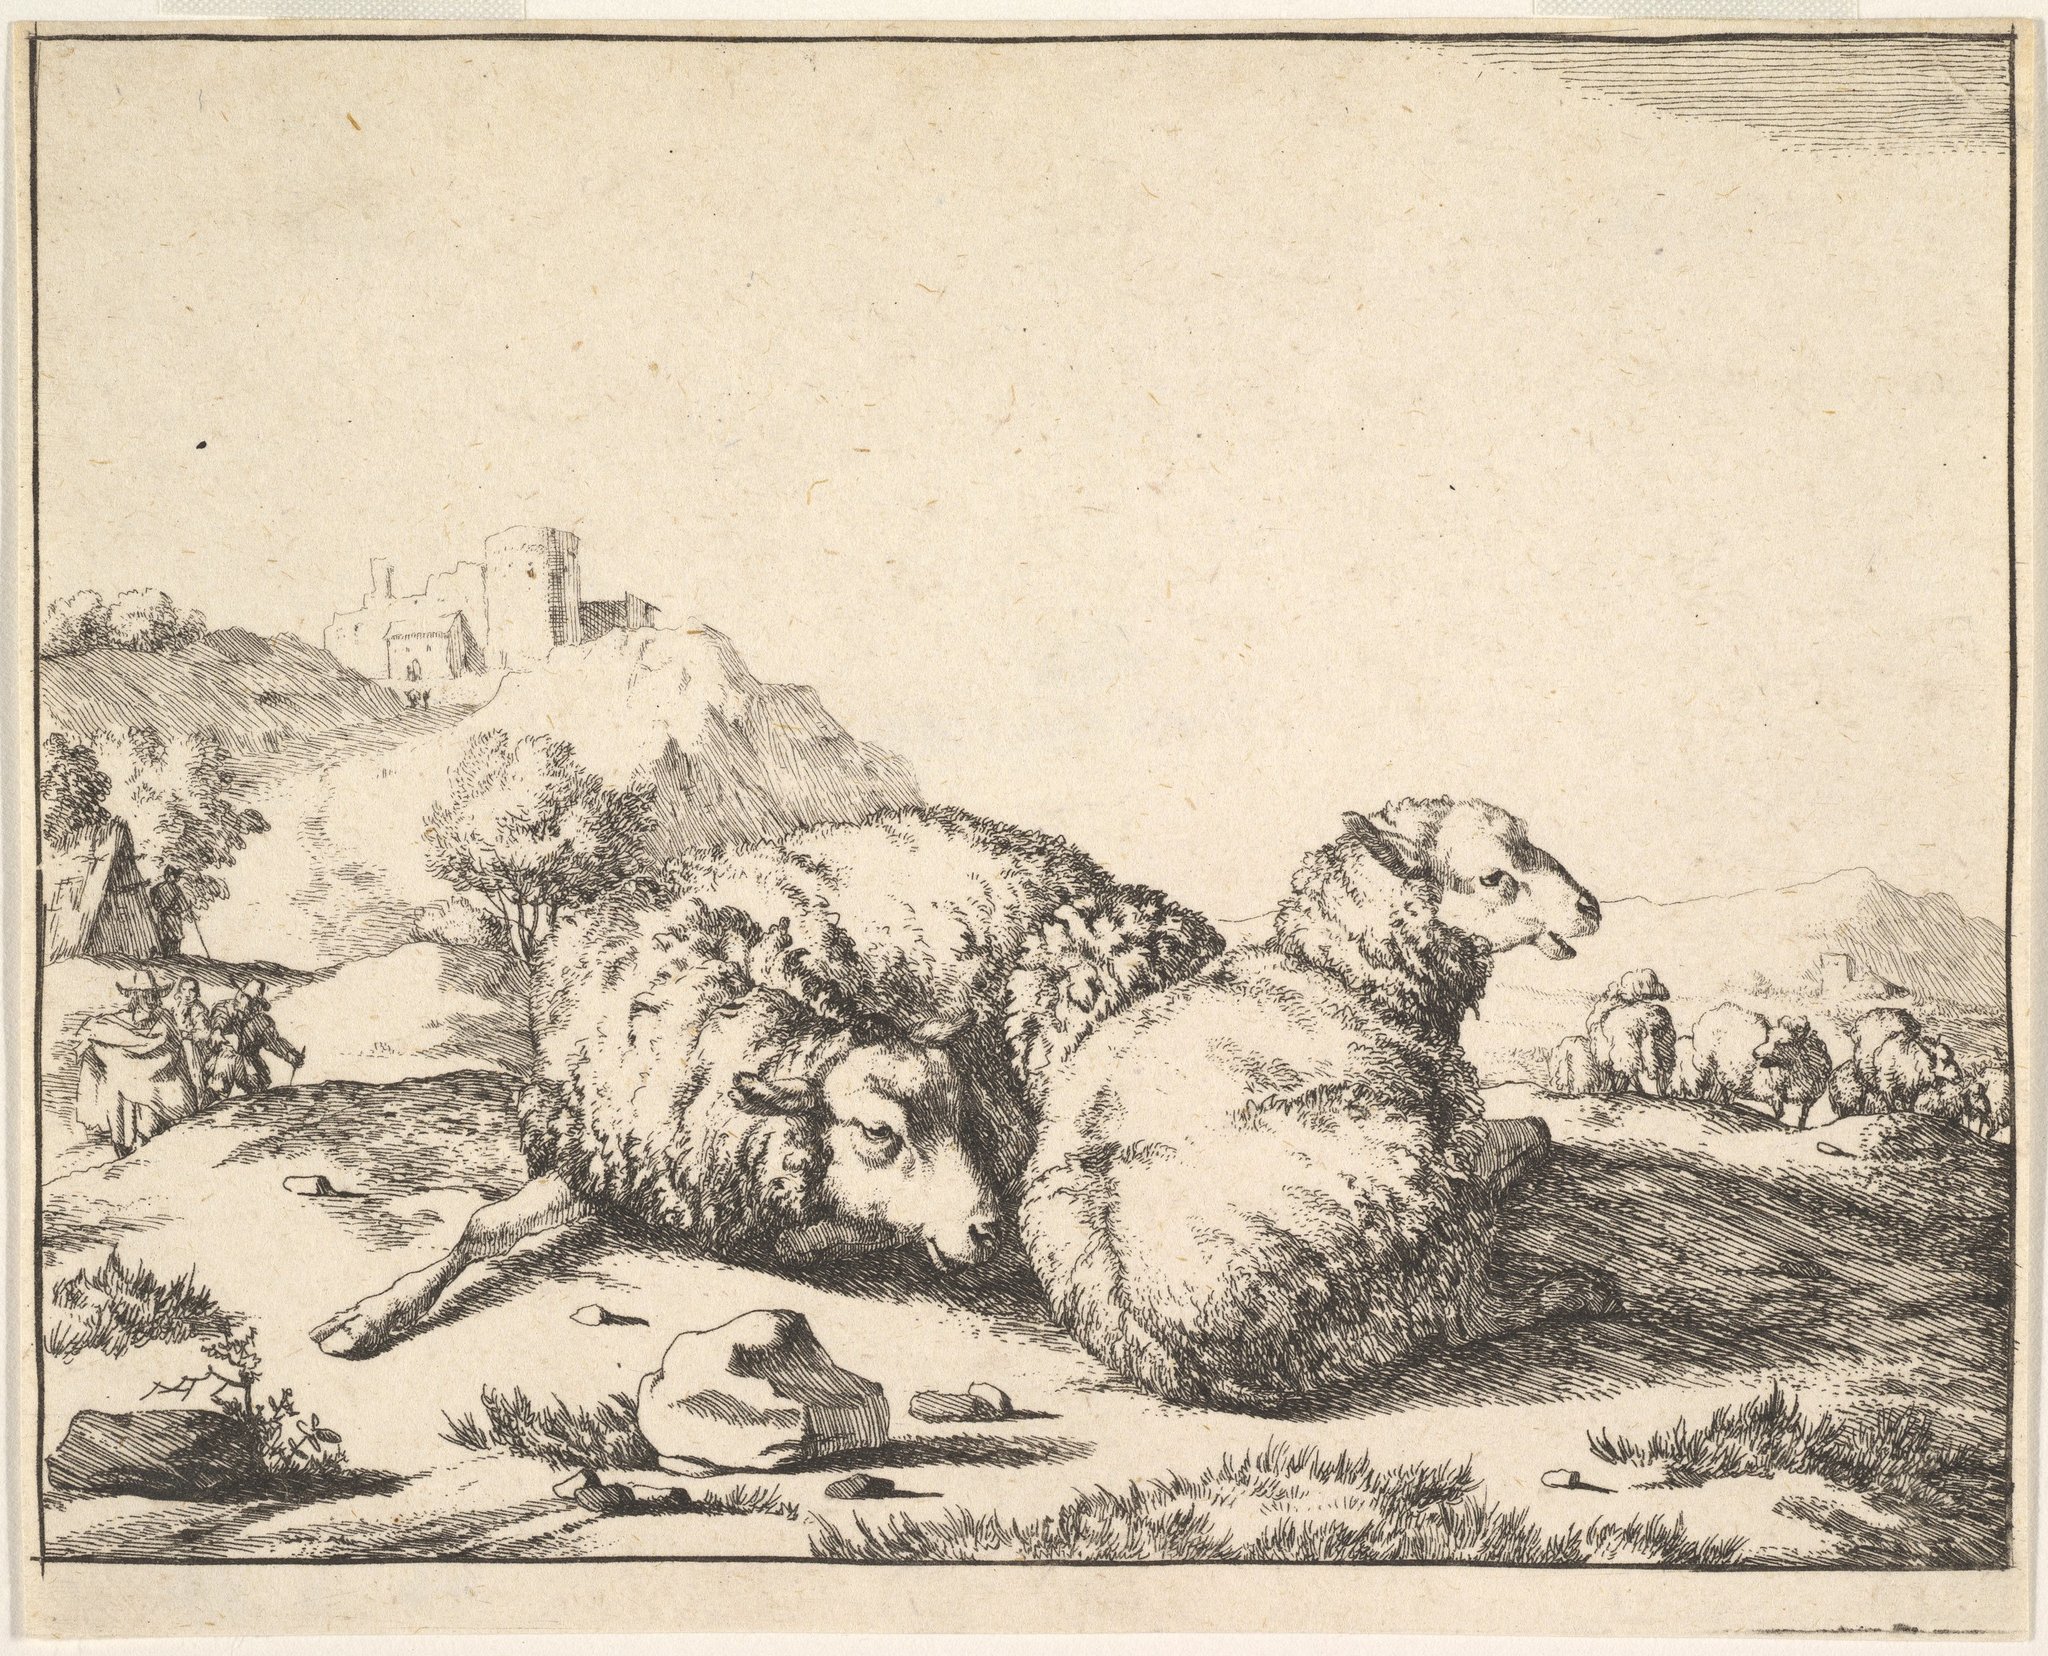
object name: print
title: Sheep, from a set of 16 plates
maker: marcus de bye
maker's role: artist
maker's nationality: dutch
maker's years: 1639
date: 1664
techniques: etching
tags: sheep